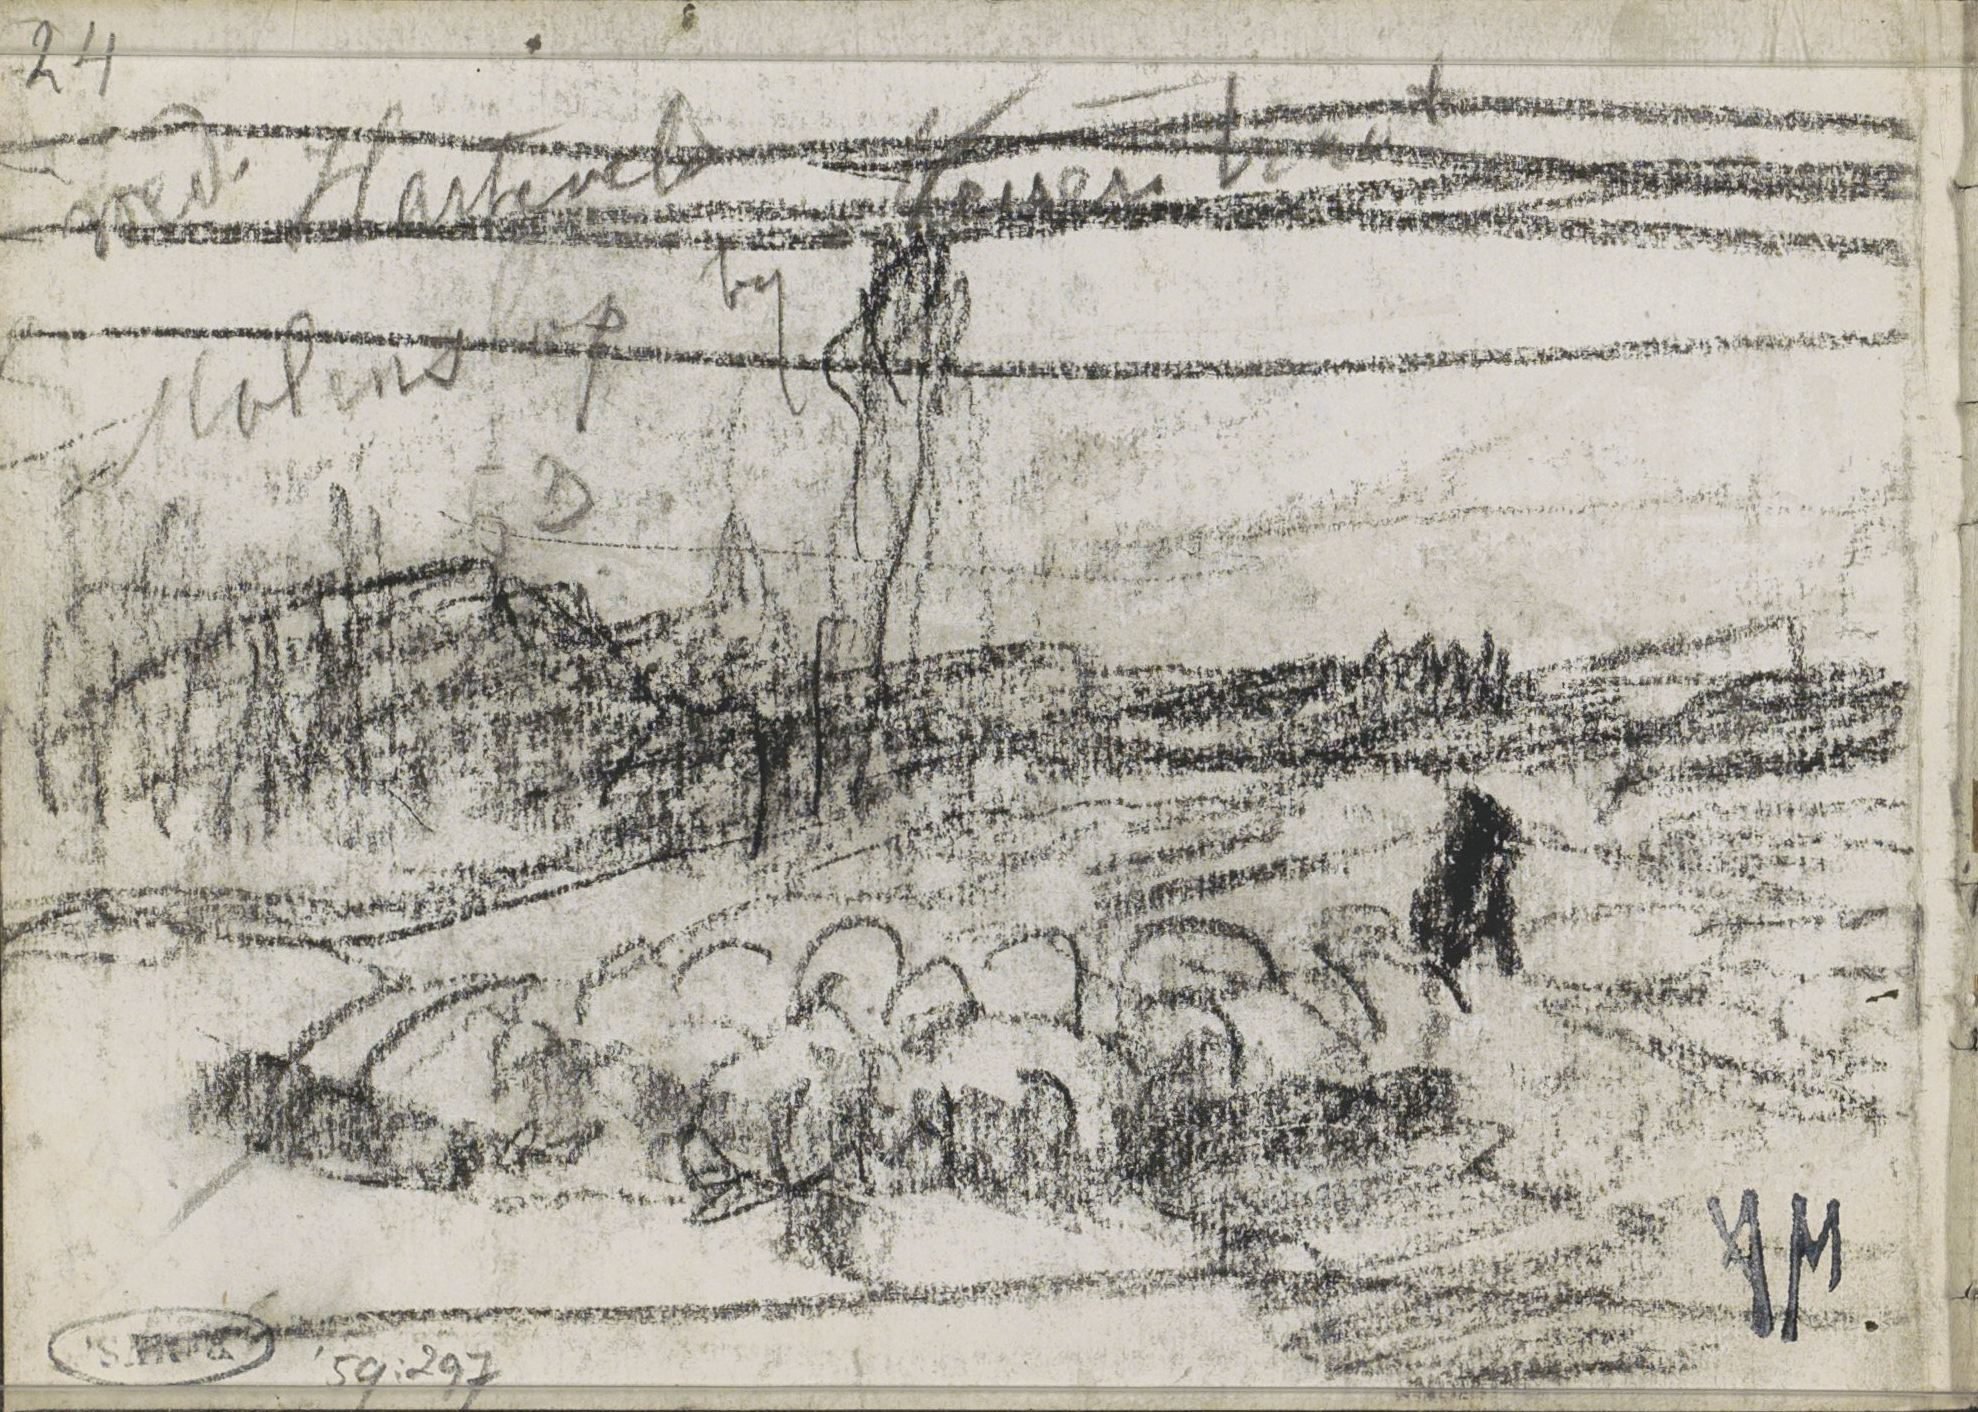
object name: endleaf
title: Herder met een schaapskudde in een landschap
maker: anton mauve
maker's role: draughtsman, painter, print maker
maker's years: 1838-1888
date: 1848-1888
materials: chalk, paper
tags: herding, herdsman, herdswoman, shepherd, shepherdess, cowherd, etc., sheep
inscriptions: annotation: ‘goed. Harteveld [...]/ Molens[...]p/ 53’, collector's mark: Lugt L. 2228a, monogram: ‘AM.’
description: Voorste schutblad uit een schetsboek met 31 bladen.